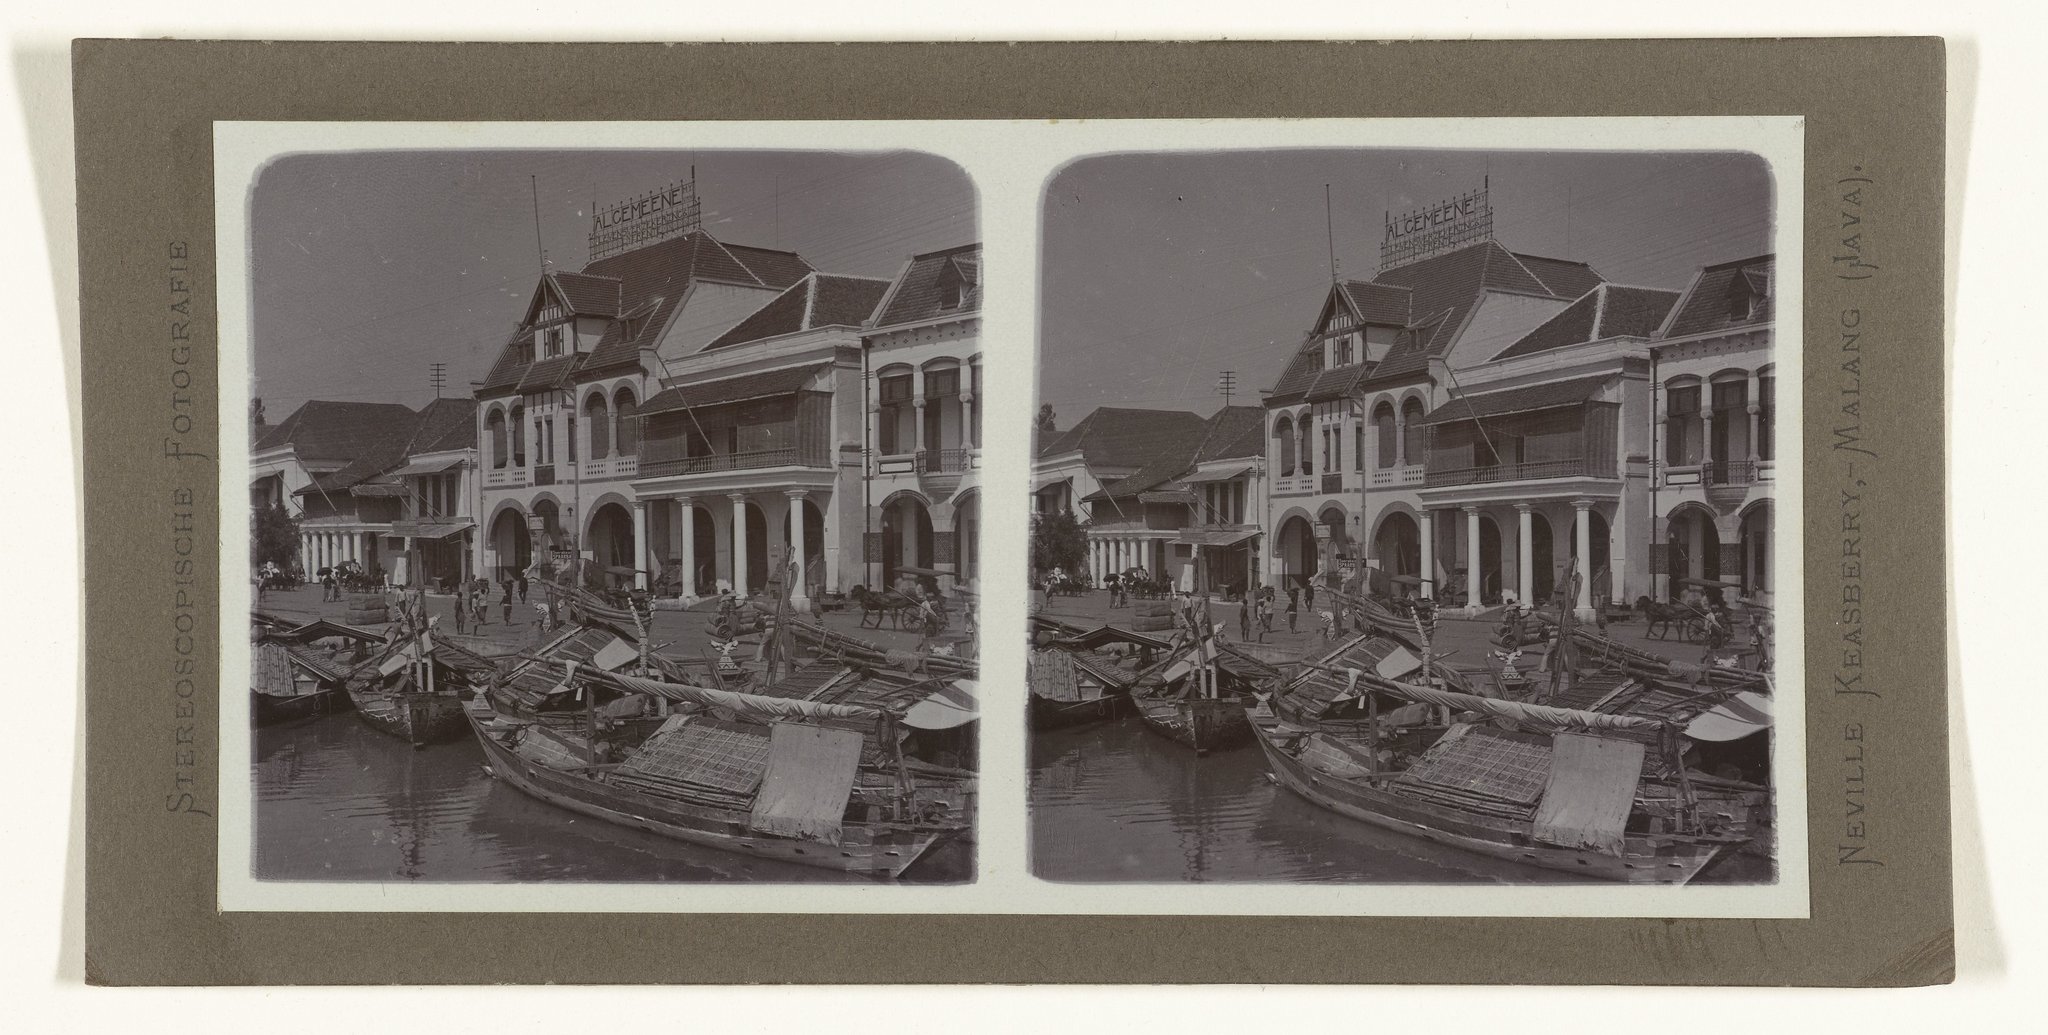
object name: stereograph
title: Gezicht op de Willemskade in Surabaya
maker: neville keasberry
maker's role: fotograaf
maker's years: 1866-1944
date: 1900-1935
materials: cardboard, paper, photographic support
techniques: albumen print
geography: malang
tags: surabaya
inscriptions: signature: ‘Neville Keasberry, Malang (Java)’, inscription: ‘Stereoscopische Fotografie’, annotation: ‘S 5 no 49. Soerabaija. De Willemskade.’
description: Ter hoogte van het gebouw van de Algemeene Levensverzekering lyfrente maatschappij.